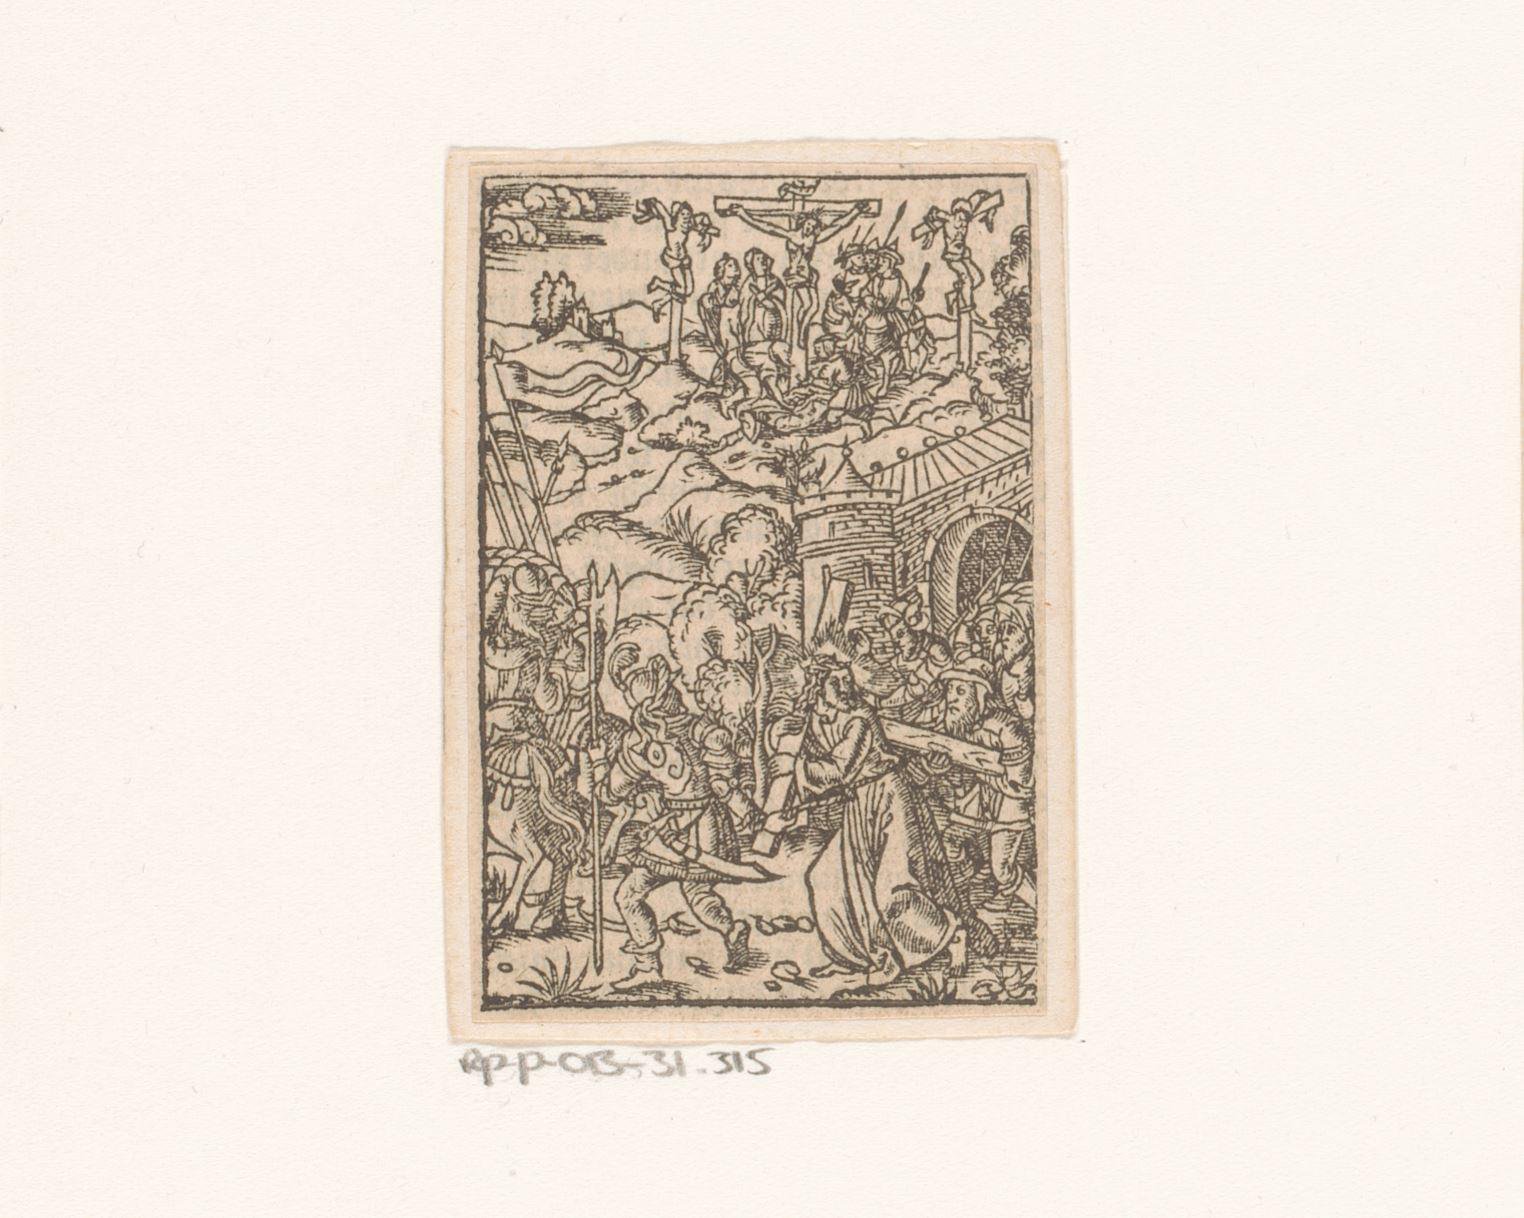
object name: book illustration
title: Kruisdraging en Christus aan het kruis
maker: Anonymous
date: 1600-1699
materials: paper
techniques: letterpress printing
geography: netherlands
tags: crucified christ, with particular persons under the cross, carrying of the cross: christ bearing the cross, alone or with the help of others (e.g. simon the cyrenian)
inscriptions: collector's mark: Lugt 240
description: Omringd door soldaten draagt Christus het kruis. Op de achtergrond hangt Christus aan het kruis met links en rechts van hem de gekruisigde misdadigers.